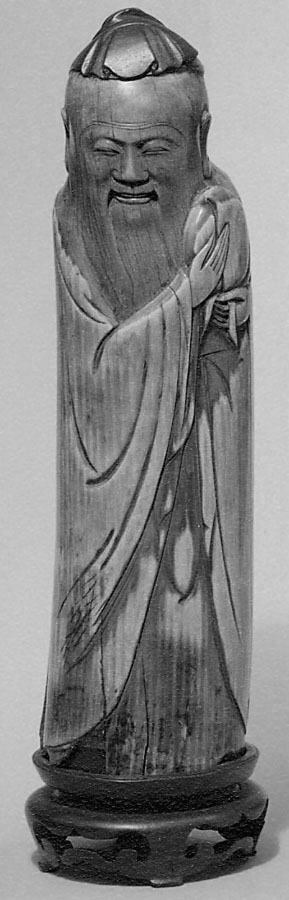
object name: statuette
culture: chinese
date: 1401-1500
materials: ivory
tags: men